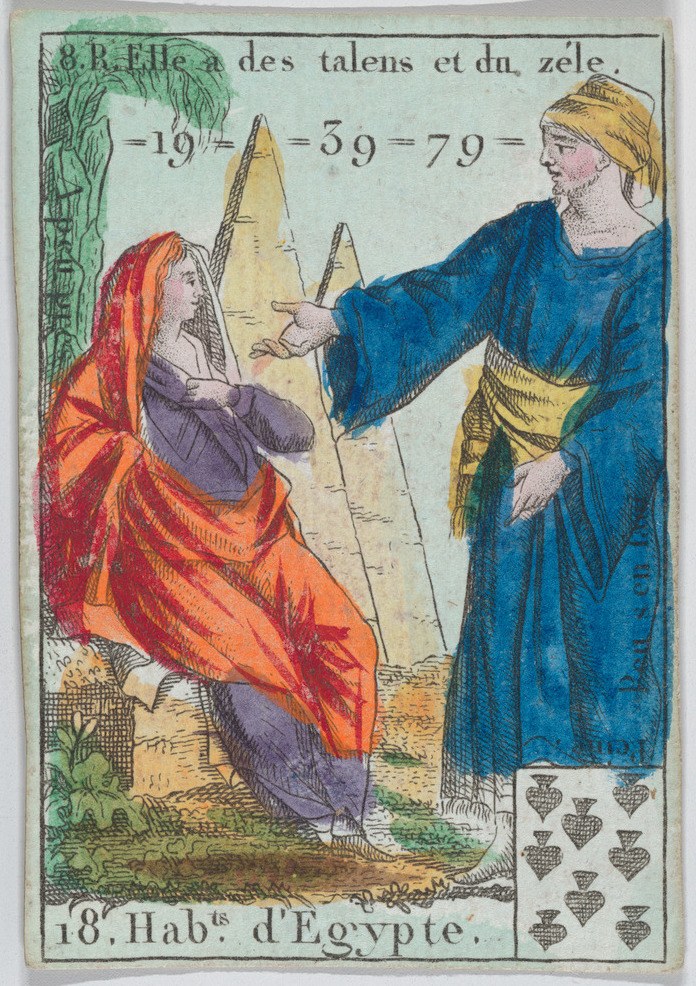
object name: print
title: Hab.ts d'Egypte from playing cards "Jeu d'Or"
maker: anonymous, french, 18th century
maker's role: artist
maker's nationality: french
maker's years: 1700-1800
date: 1700-1799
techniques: etching, hand coloring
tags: men,profiles,women,playing cards